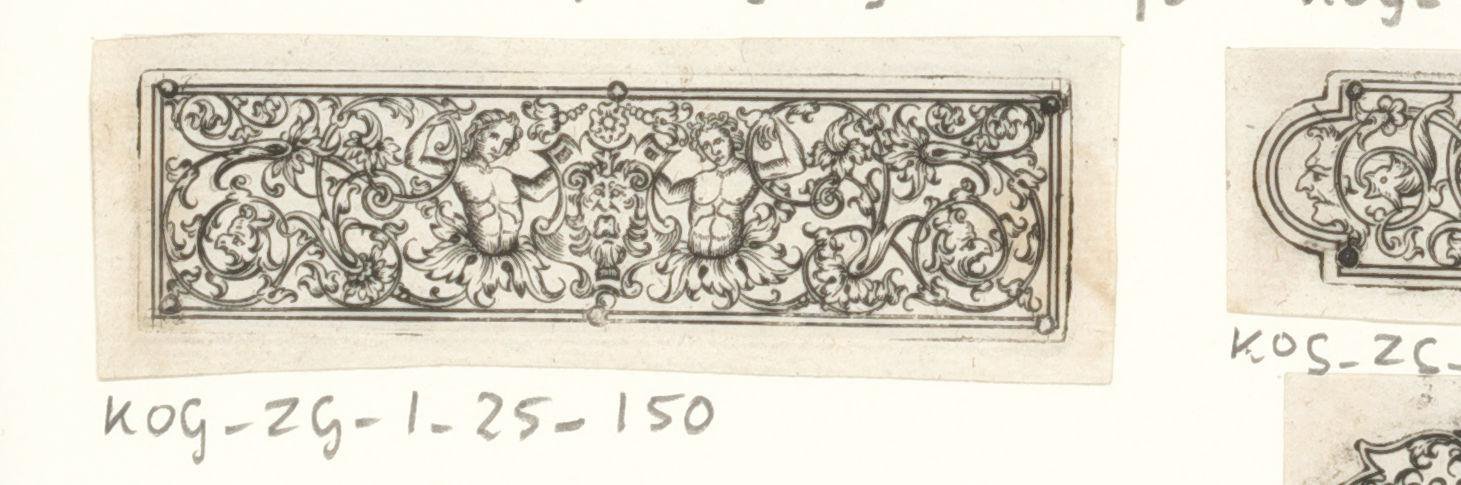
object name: ornament print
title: Twee torso's van mannen in ornamentele omlijsting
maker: Anonymous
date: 1600-1699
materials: paper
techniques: engraving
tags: adult man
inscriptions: collector's mark: Lugt 963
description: Onderwerpsrubrieken binnen de Atlas Zeden en Gewoonten: Zeden en Gewoonten in Engeren Zin, De Woning, Huisraad, Zilverwerk.